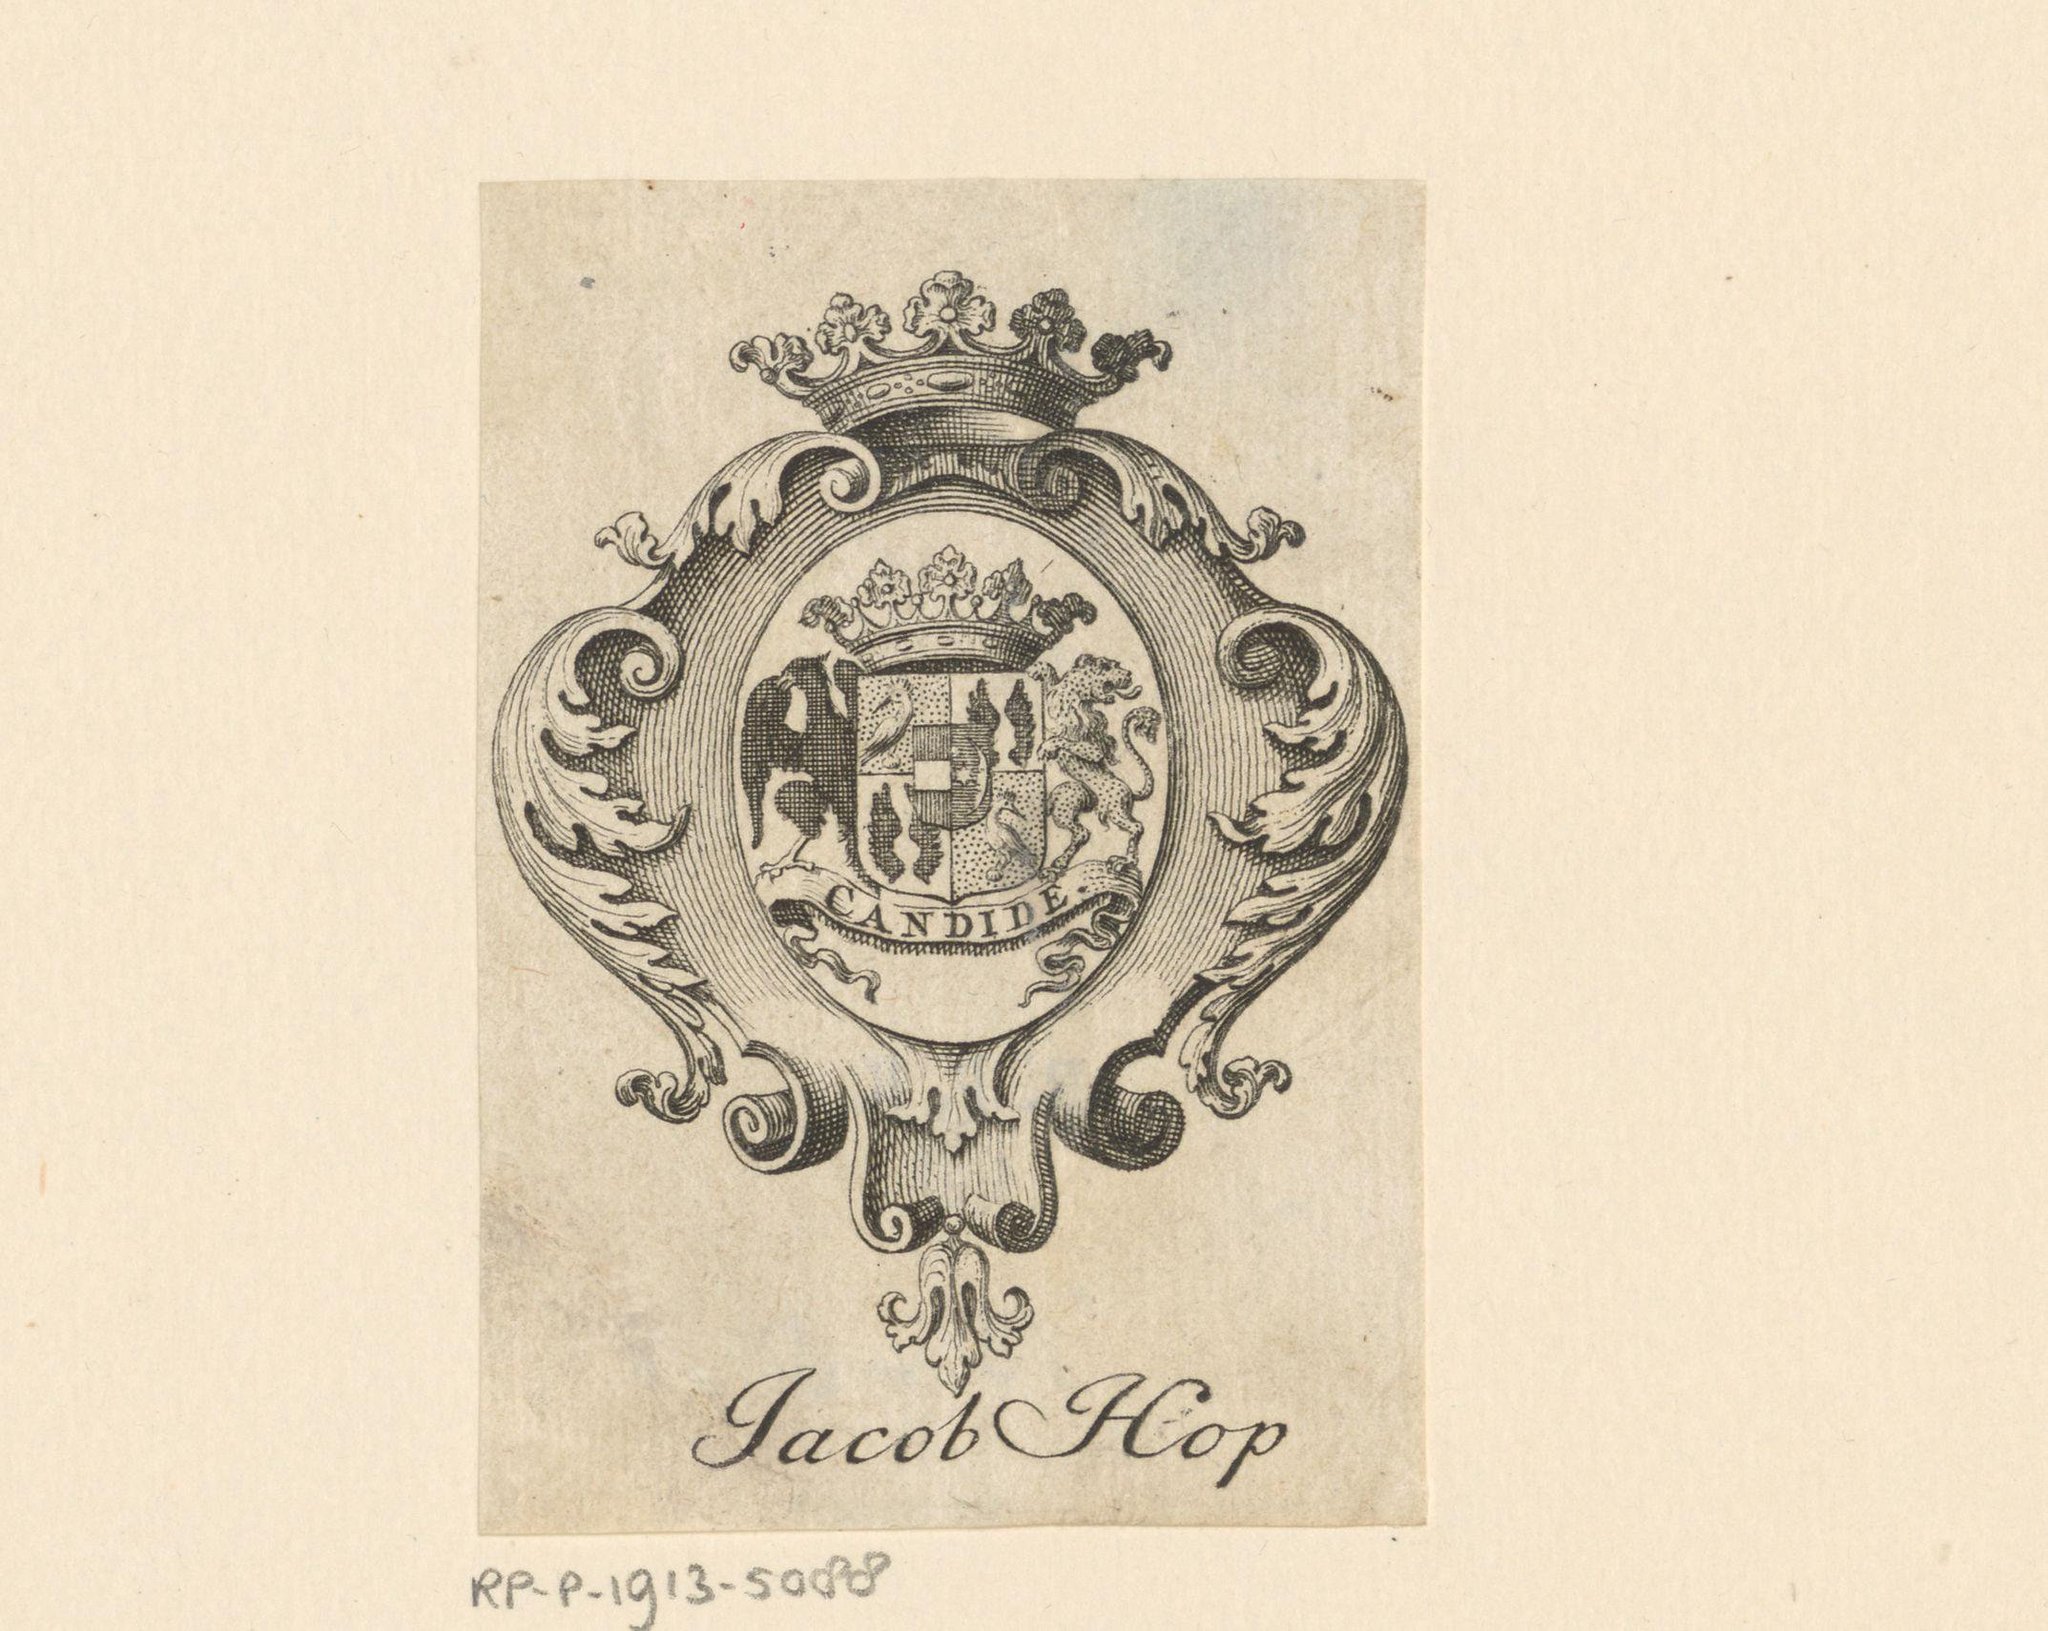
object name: bookplate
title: Ex libris van Jacob Hop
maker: Anonymous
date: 1664-1725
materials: paper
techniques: etching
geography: netherlands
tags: predatory birds: eagle, beasts of prey, predatory animals: lion, armorial bearing, heraldry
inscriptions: collector's mark: Lugt 2760, collector's mark: Lugt 2233